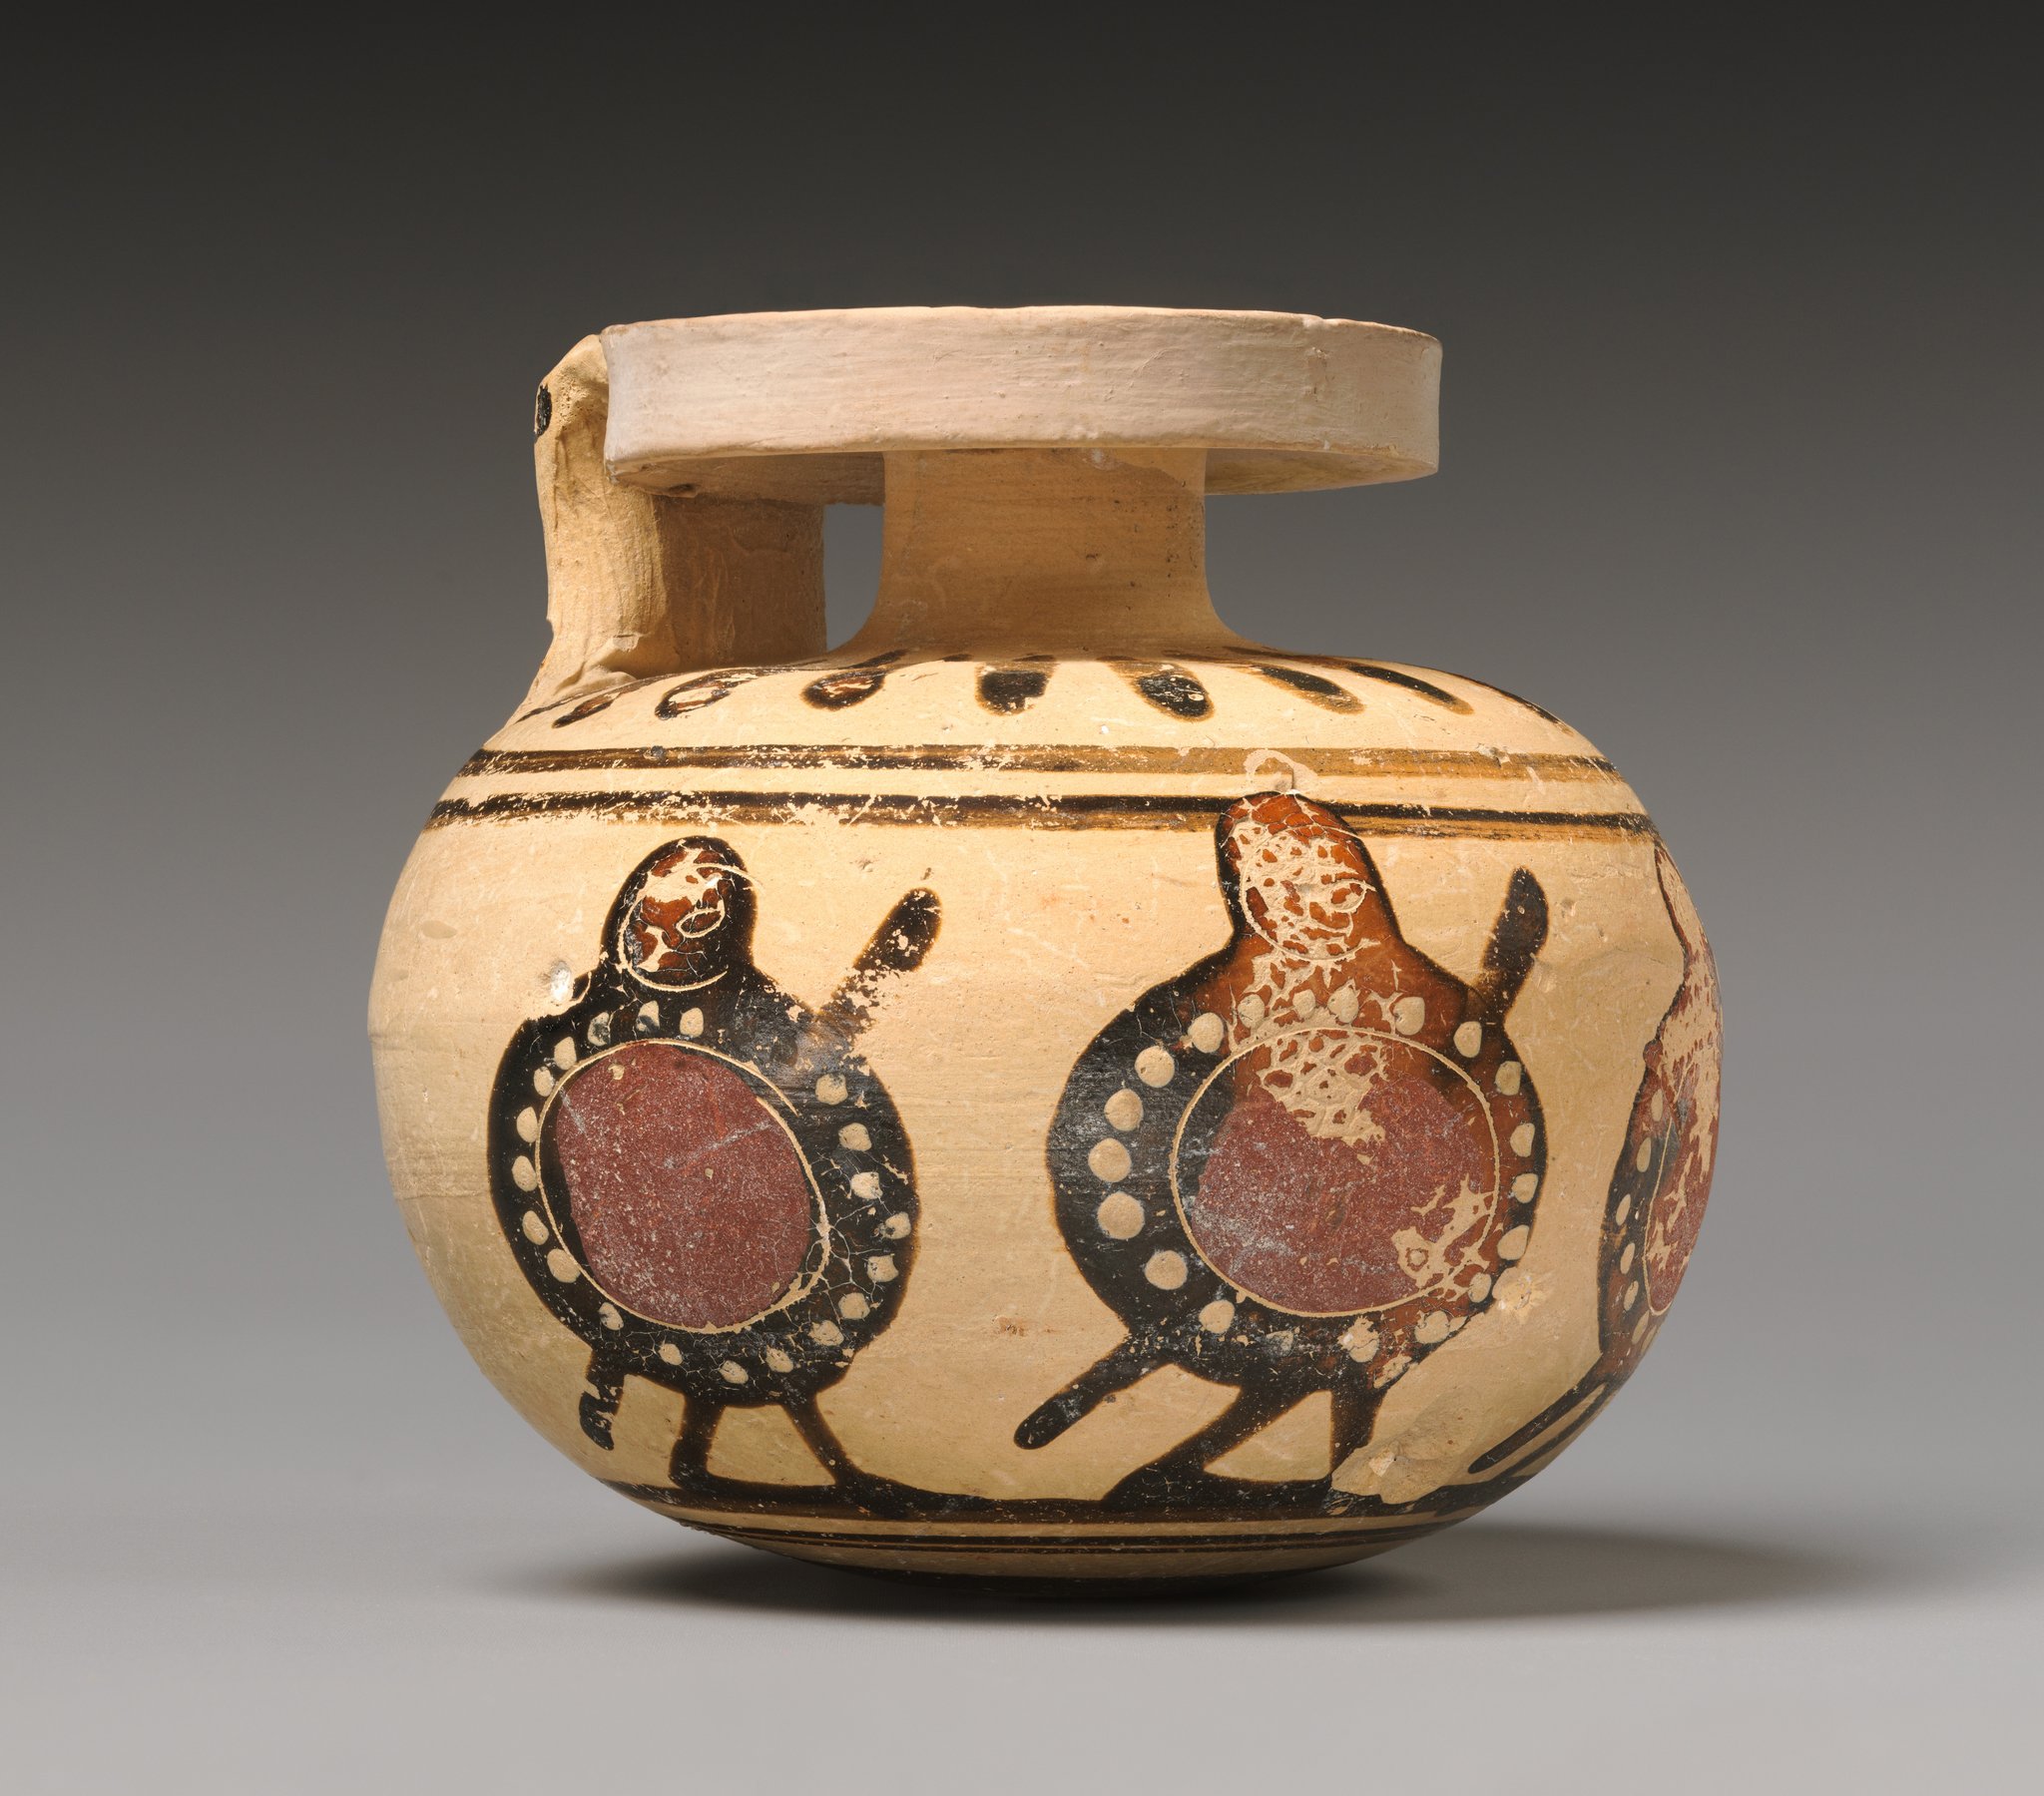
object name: aryballos with four warrior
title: Aryballos with four warriors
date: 600 BCE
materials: terracotta